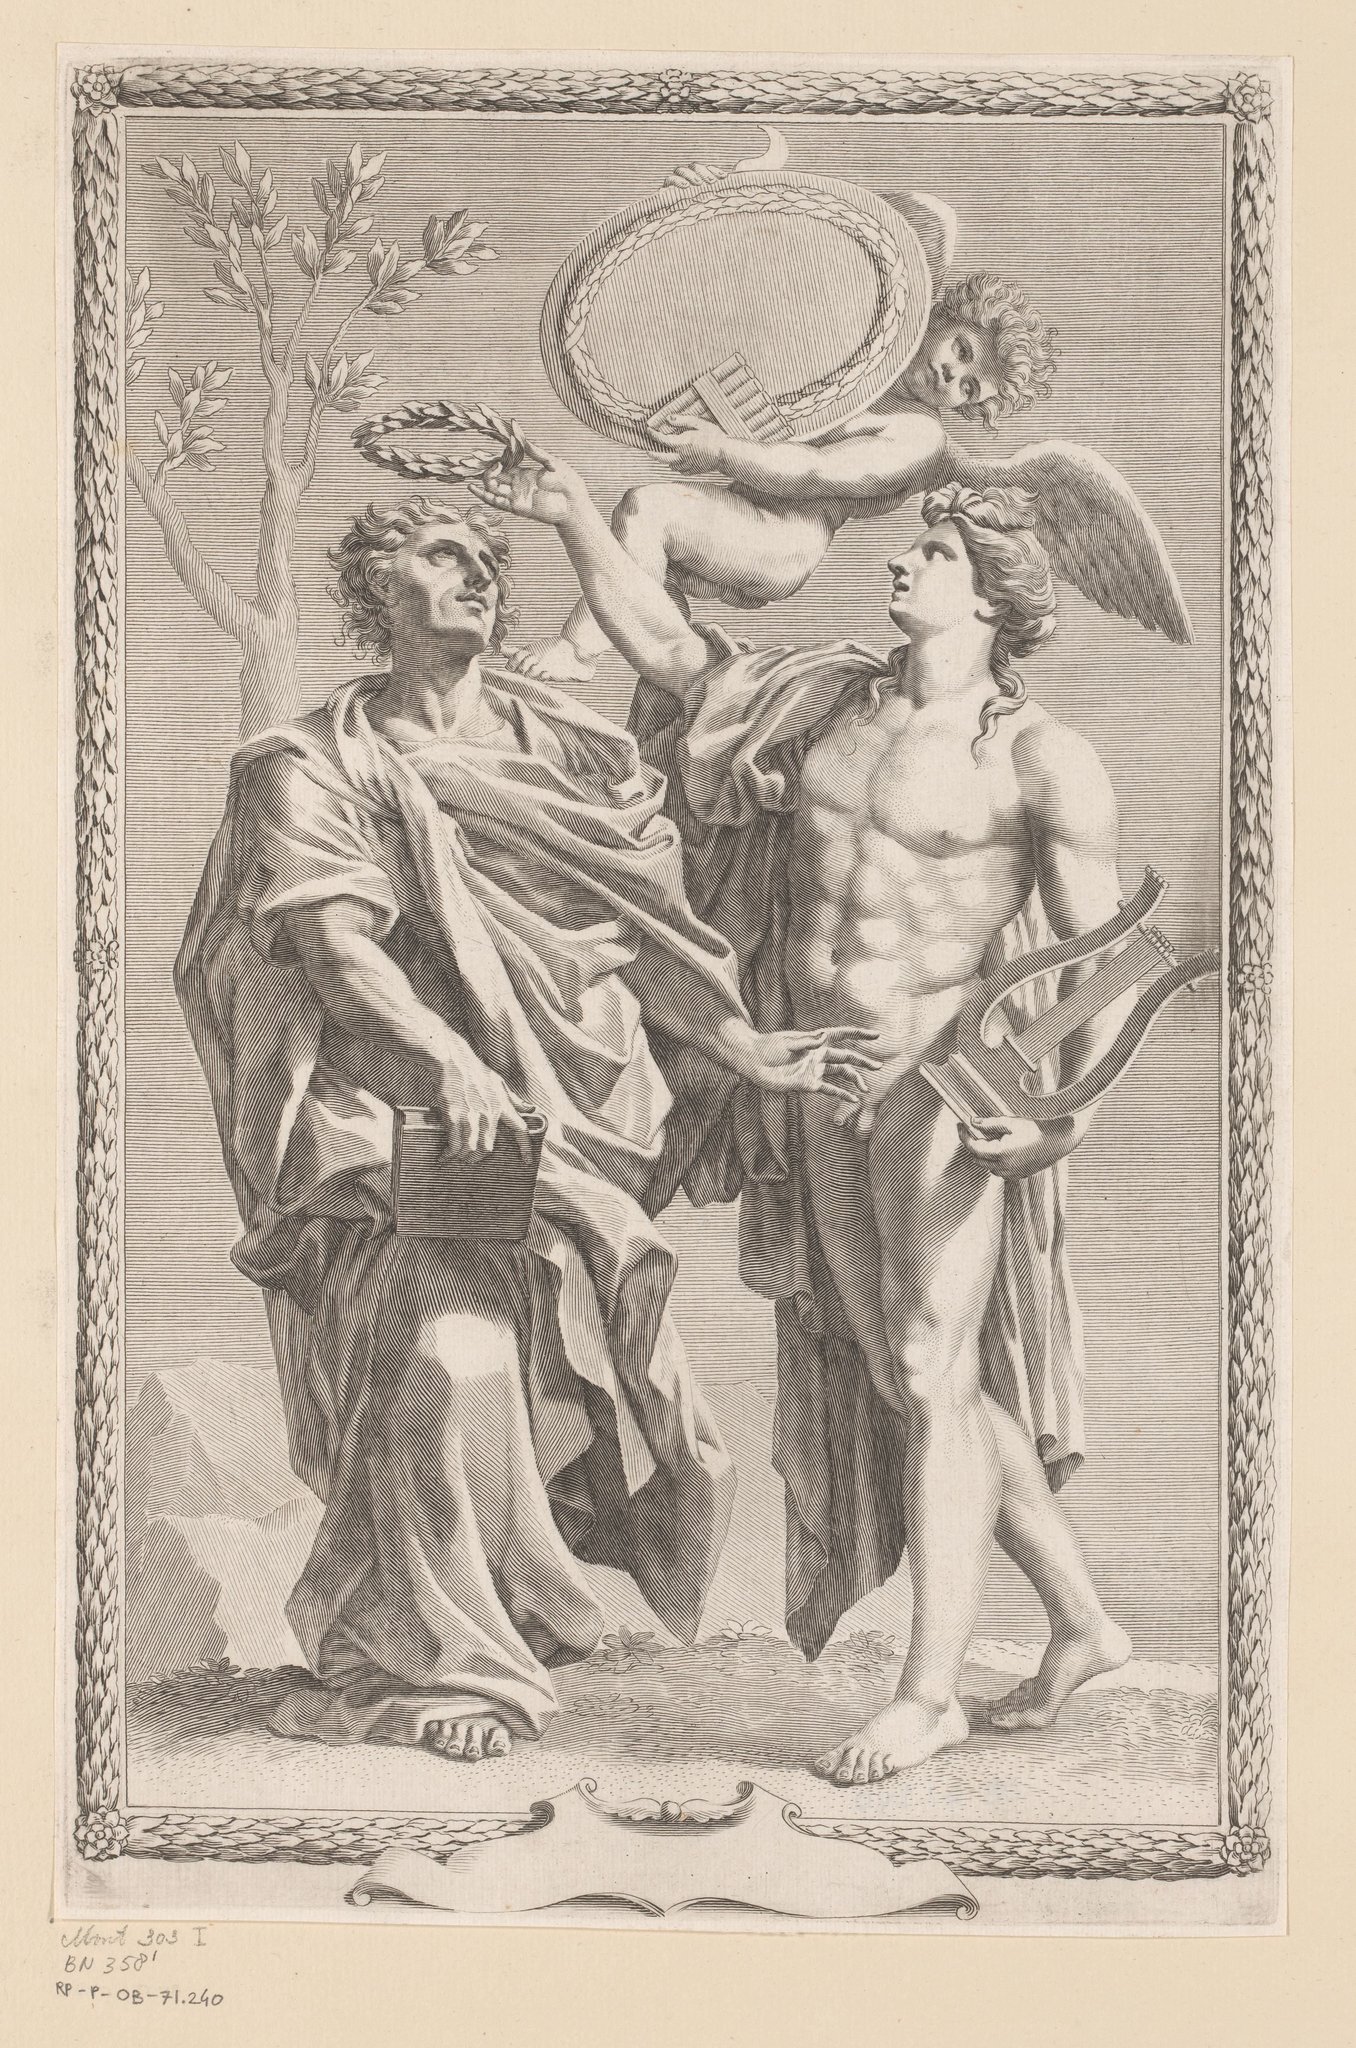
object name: titelblad, titelpagina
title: Apollo kroont Publius Vergilius Maro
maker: claude mellan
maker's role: draughtsman, print maker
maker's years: 1598-1688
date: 1641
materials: paper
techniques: engraving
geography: france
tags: publius vergilius maro, (story of) apollo (phoebus), historical persons, crowning with laurel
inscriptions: collector's mark: Lugt 240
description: Titelpagina voor: Vergilius Maro, Publius. Publii Virgilii Maronis Opera. Parijs: Imprimerie Royale, 1641. De voorbereidende tekening door Poussin bevindt zich Windsor, inv.nr. 11948.